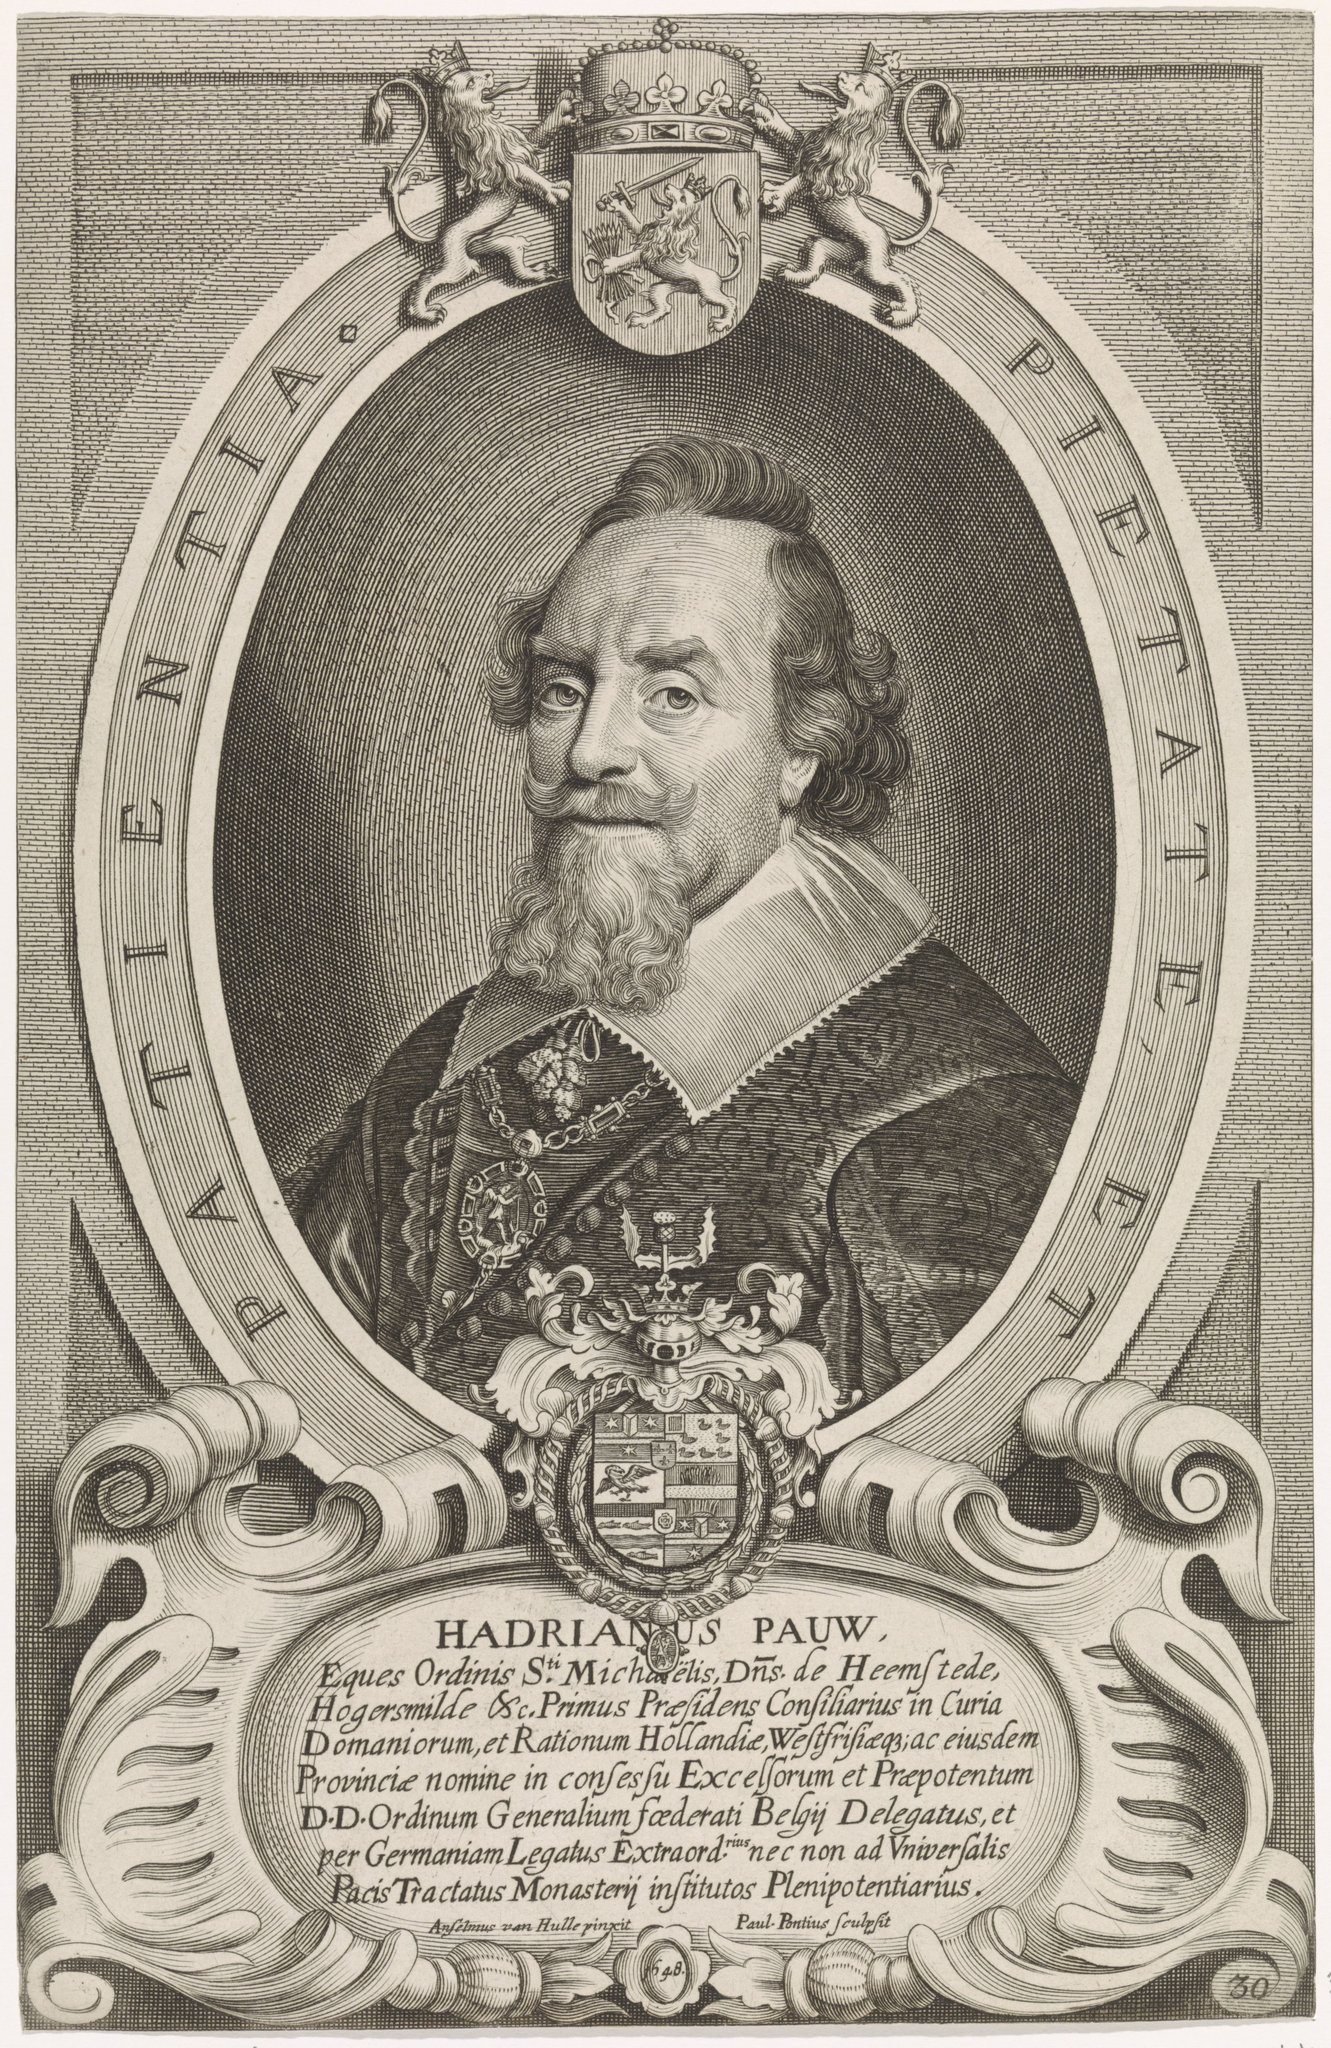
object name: print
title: Portret van Adriaen Pauw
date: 1648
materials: paper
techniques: engraving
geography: antwerp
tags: amsterdam, the hague, politician, adriaen pauw (1585-1653), armorial bearing, heraldry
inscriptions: collector's mark: Lugt 2228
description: Prent ook opgenomen in: Pacificatores orbis christiani, sive Icones principum, ducum et legatorum, qui Monasterii atque Osnabrugæ pacem Europæ reconciliarunt (...). = Pronkbeelden der vorsten, en vredehandelaars. Rotterdam: Pieter van der Slaart, 1697.